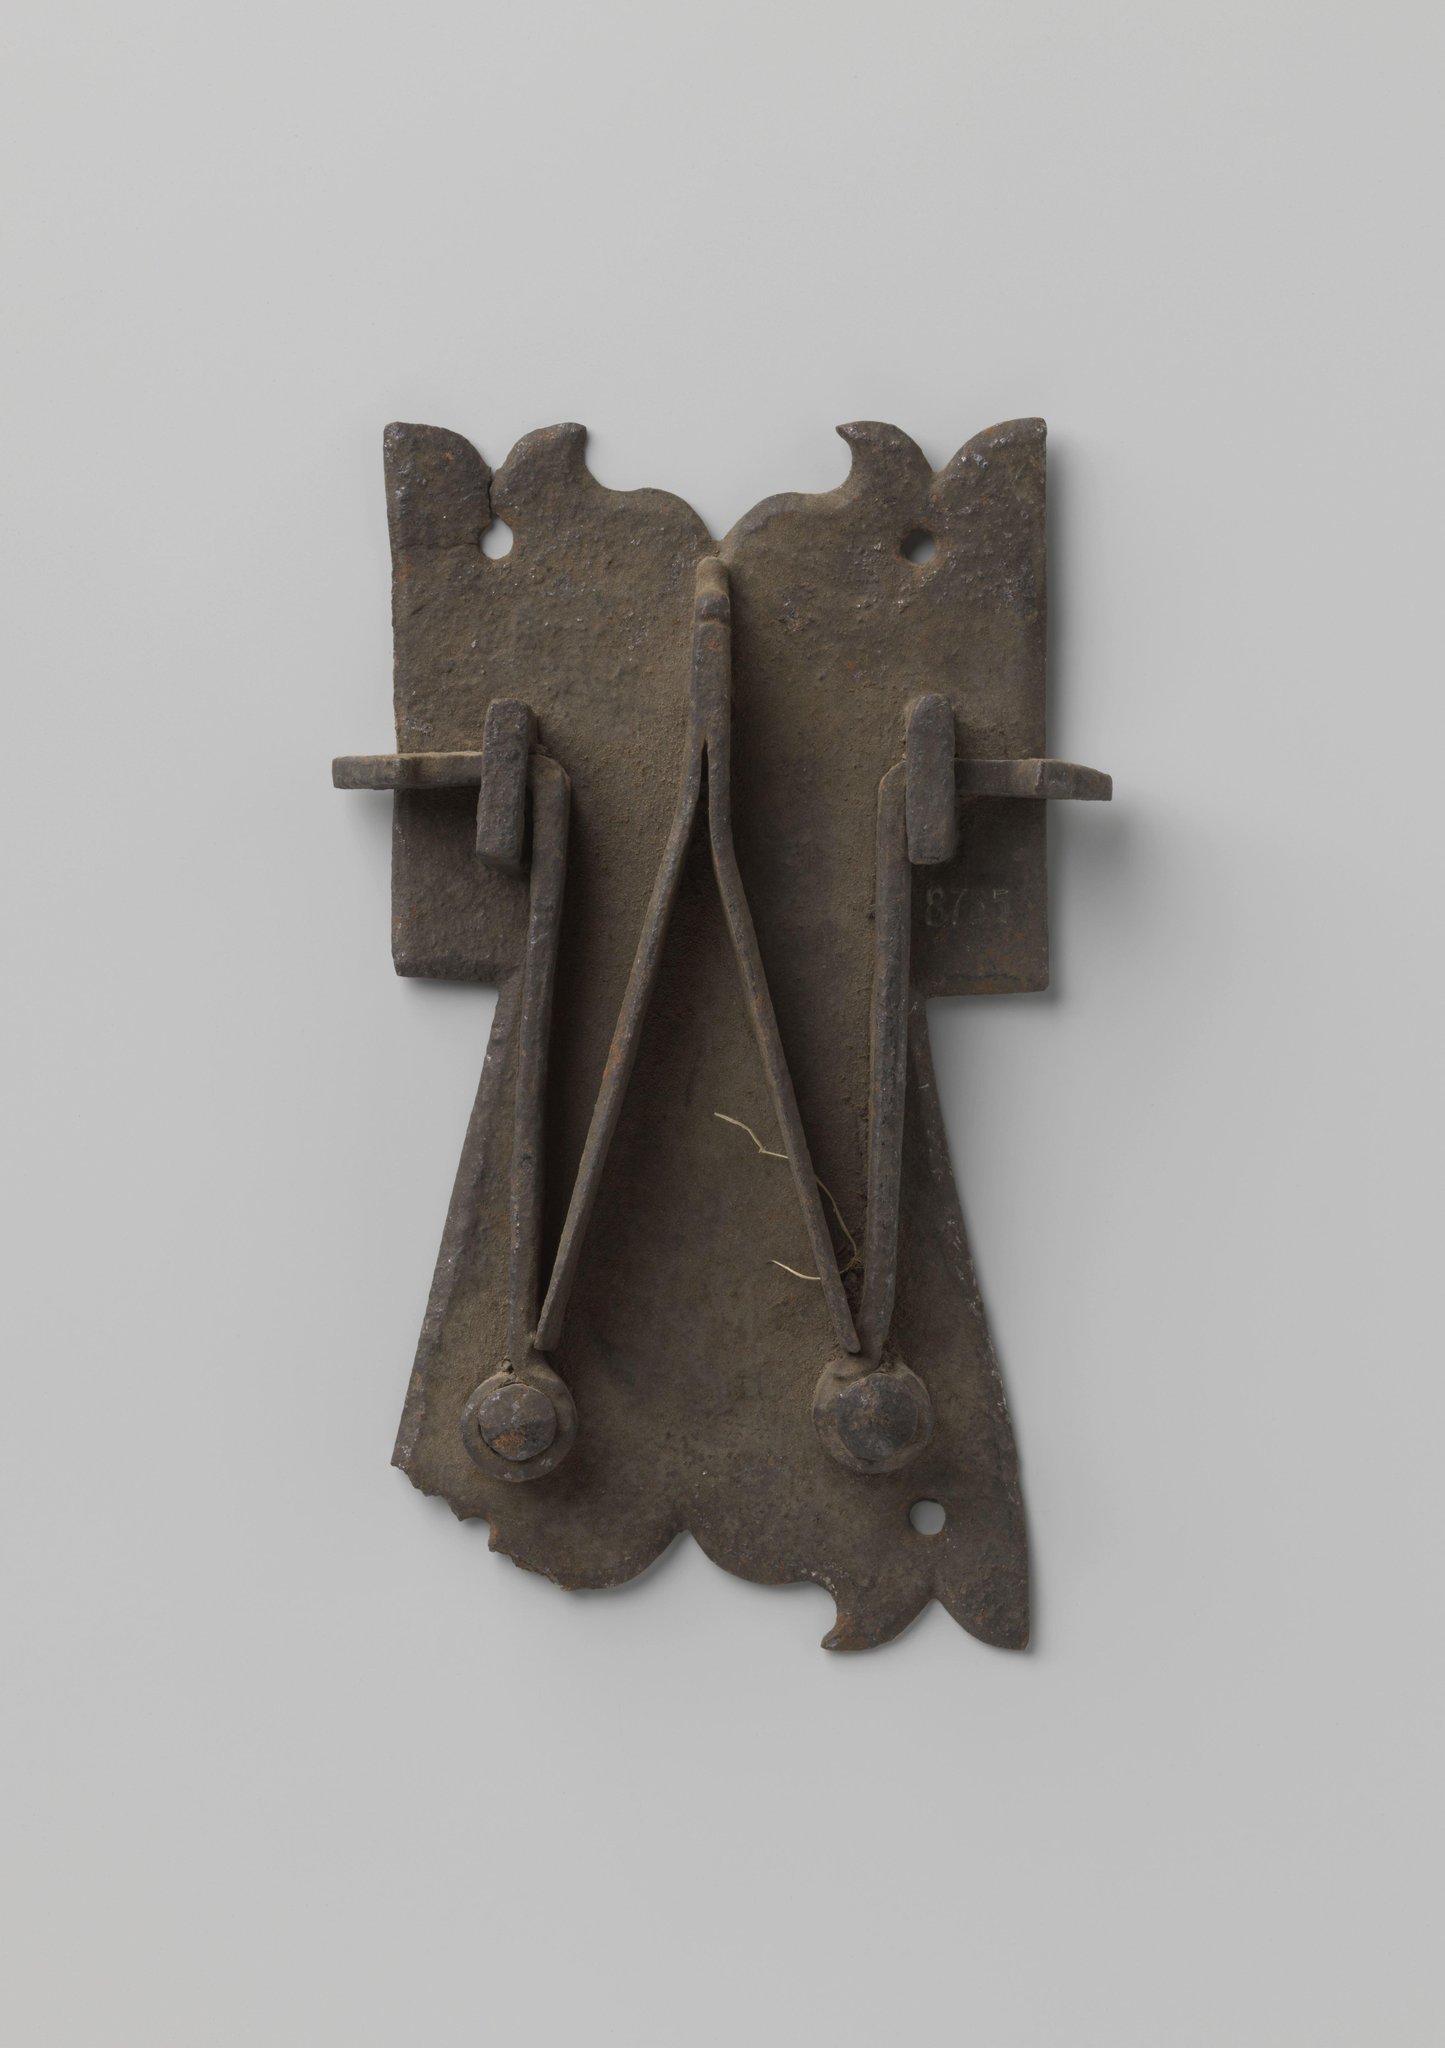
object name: knip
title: Dubbele knip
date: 1400-1950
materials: iron